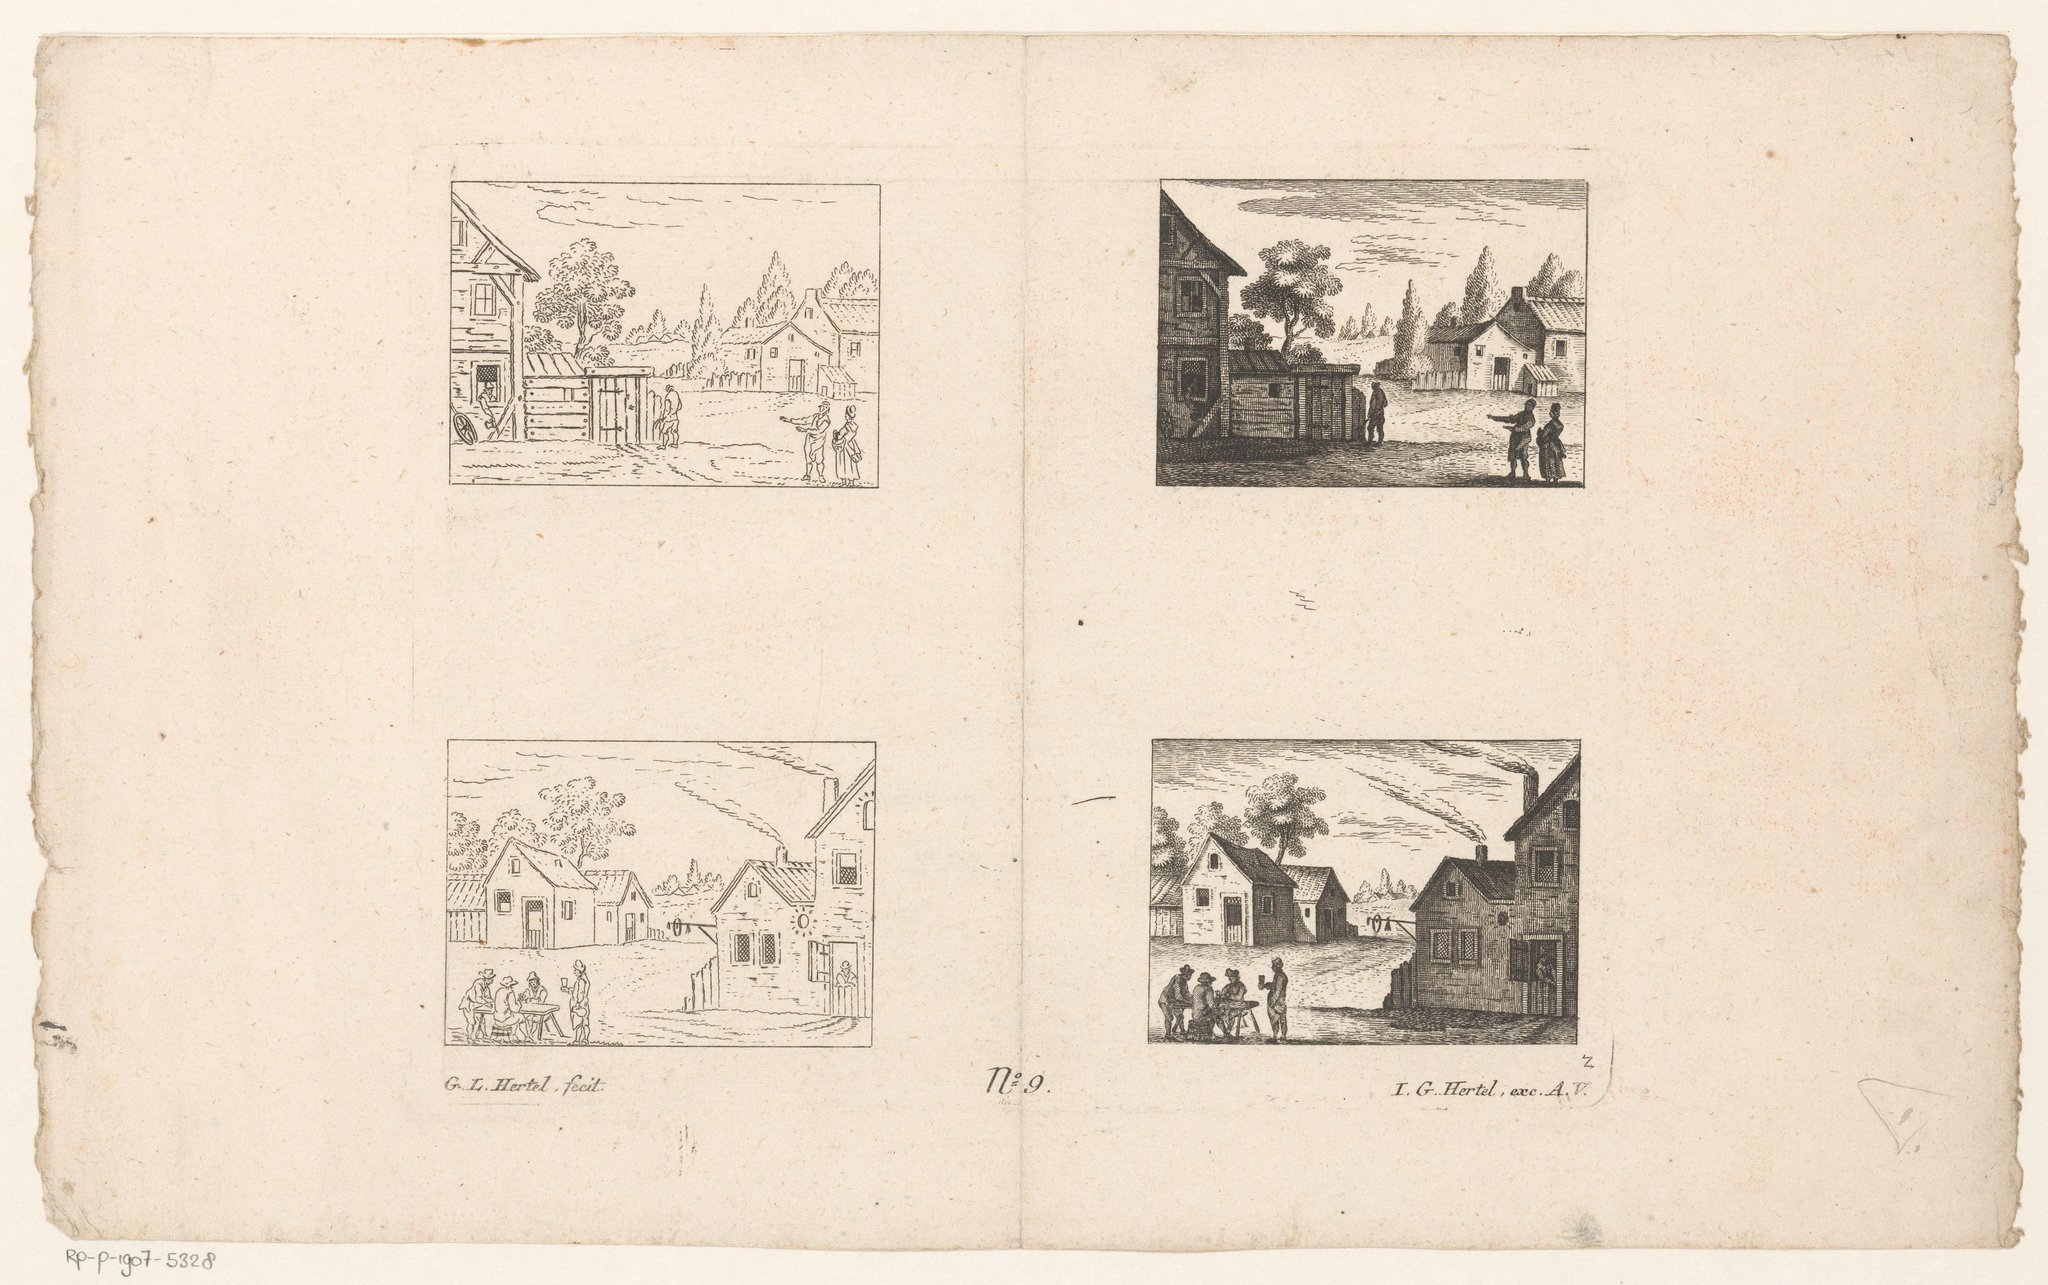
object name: print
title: Etsproces verduidelijkt in vier landschappen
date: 1750-1778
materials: paper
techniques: etching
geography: augsburg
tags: prospect of village, silhouette of village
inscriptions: collector's mark: Lugt 2228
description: Het creatieve proces van de etser verduidelijkt in vier landschappen. Links twee landschappen voor opwerking en arcering. Rechts dezelfde landschappen, maar ditmaal uitgewerkt. Midden onder genummerd: 9.